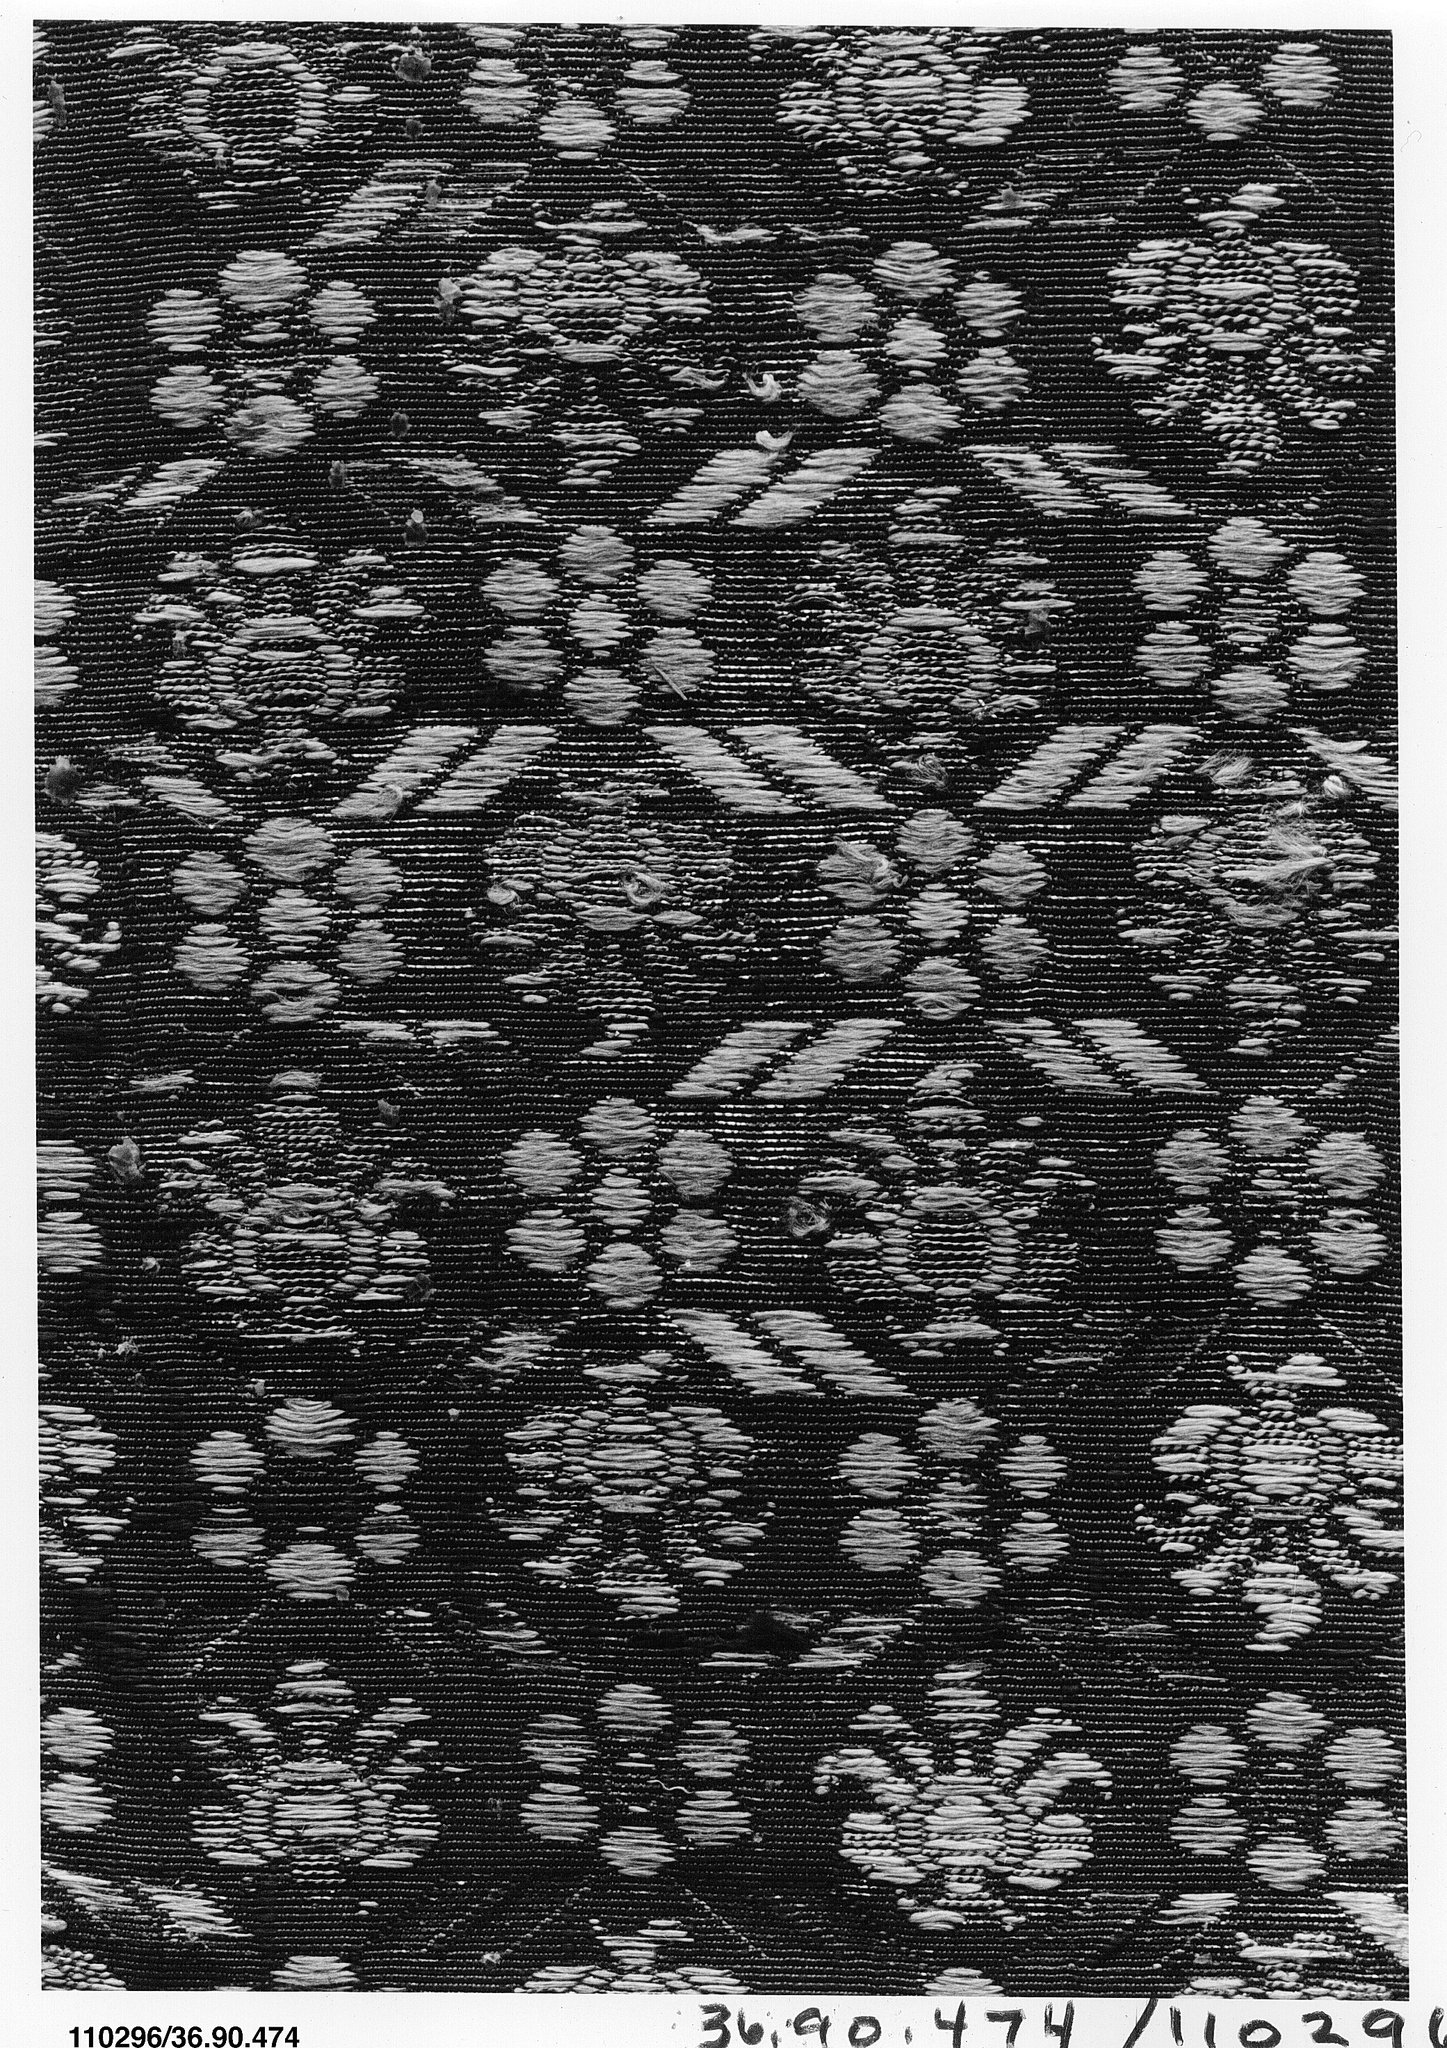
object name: piece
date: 1501-1700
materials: metal thread, silk